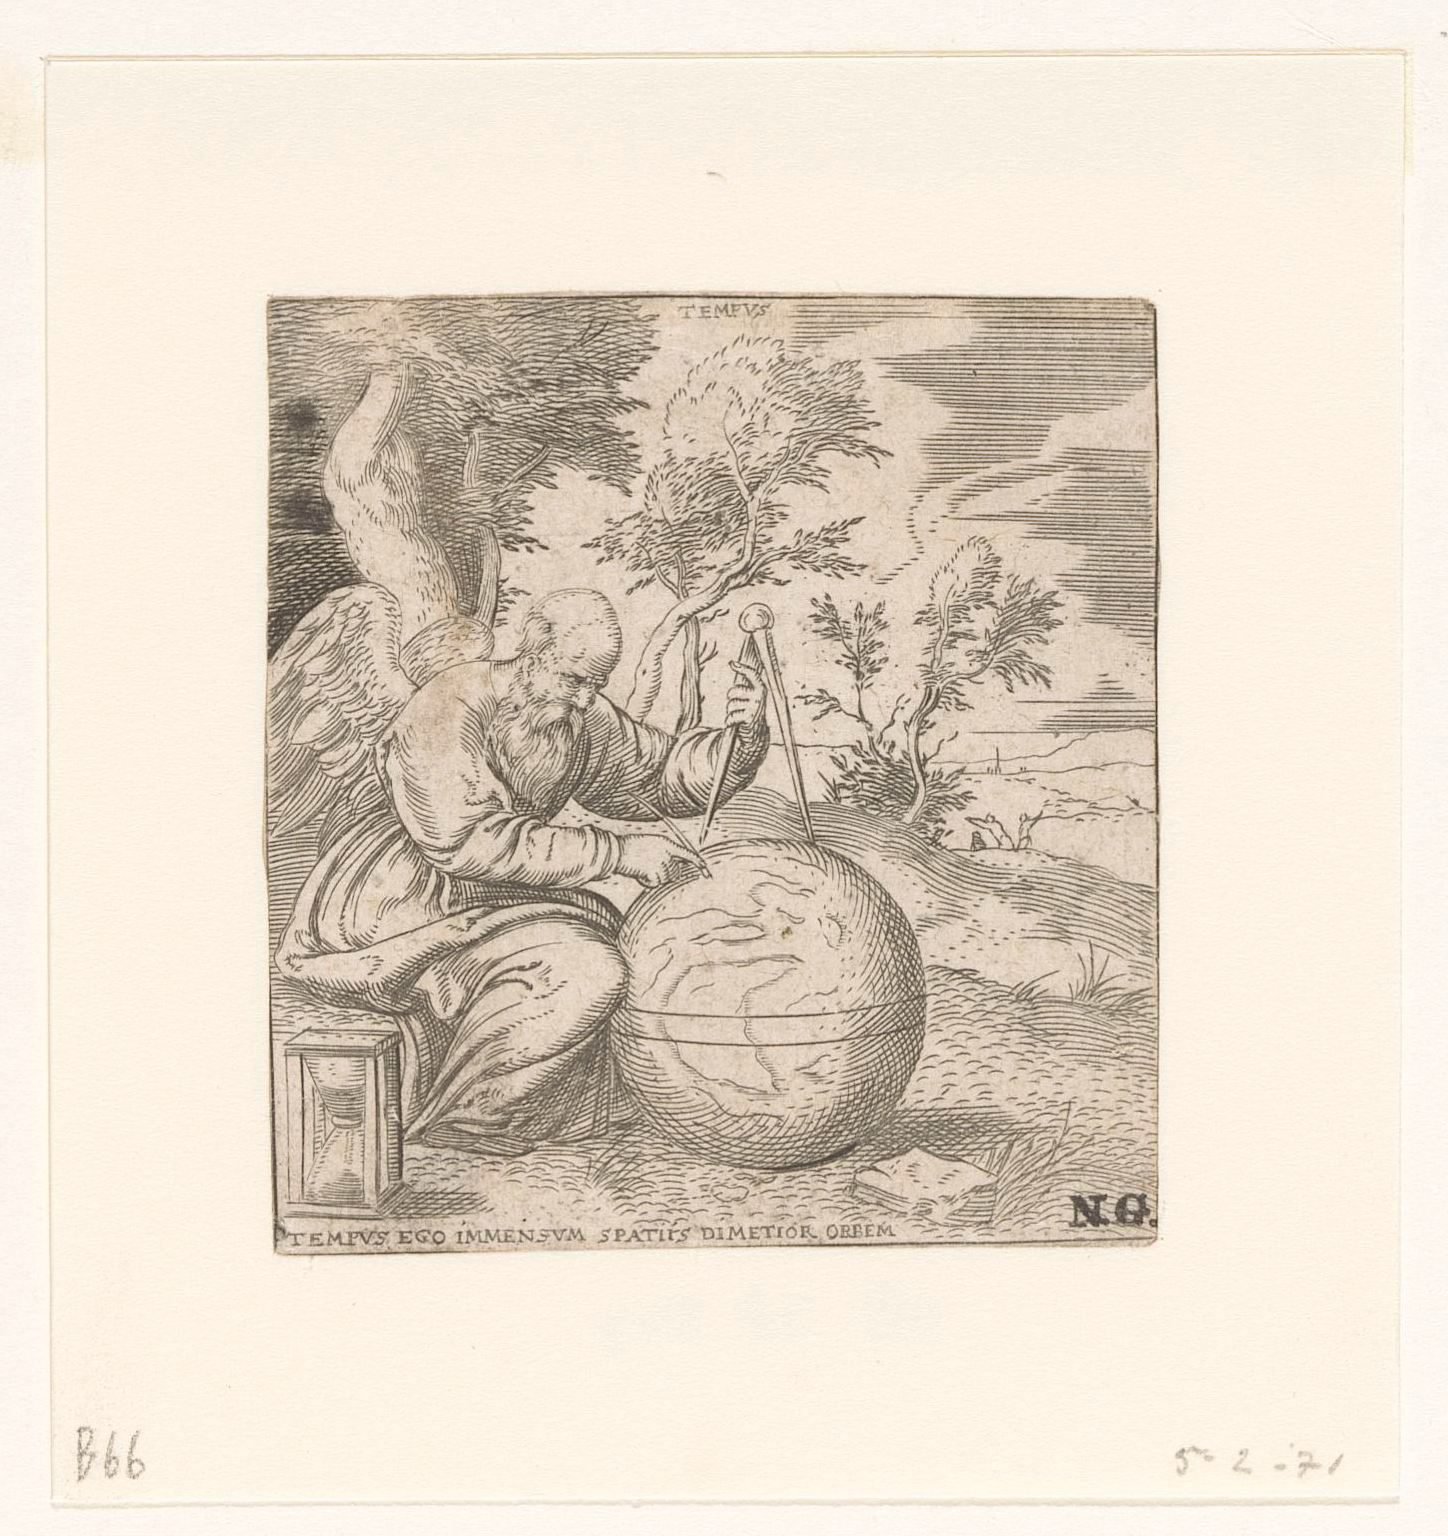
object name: print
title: Tempus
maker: francesco salviati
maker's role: draughtsman, painter, print maker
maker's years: 1510-1563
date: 1533-1567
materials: paper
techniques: engraving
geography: italy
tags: other allegories of time, e.g. 'tempo' (ripa)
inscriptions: collector's mark: Lugt 1967, collector's mark:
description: Tijd (Tempus) als oude man met een passer, wereldbol en zandloper. Onderaan een regel Latijnse tekst.